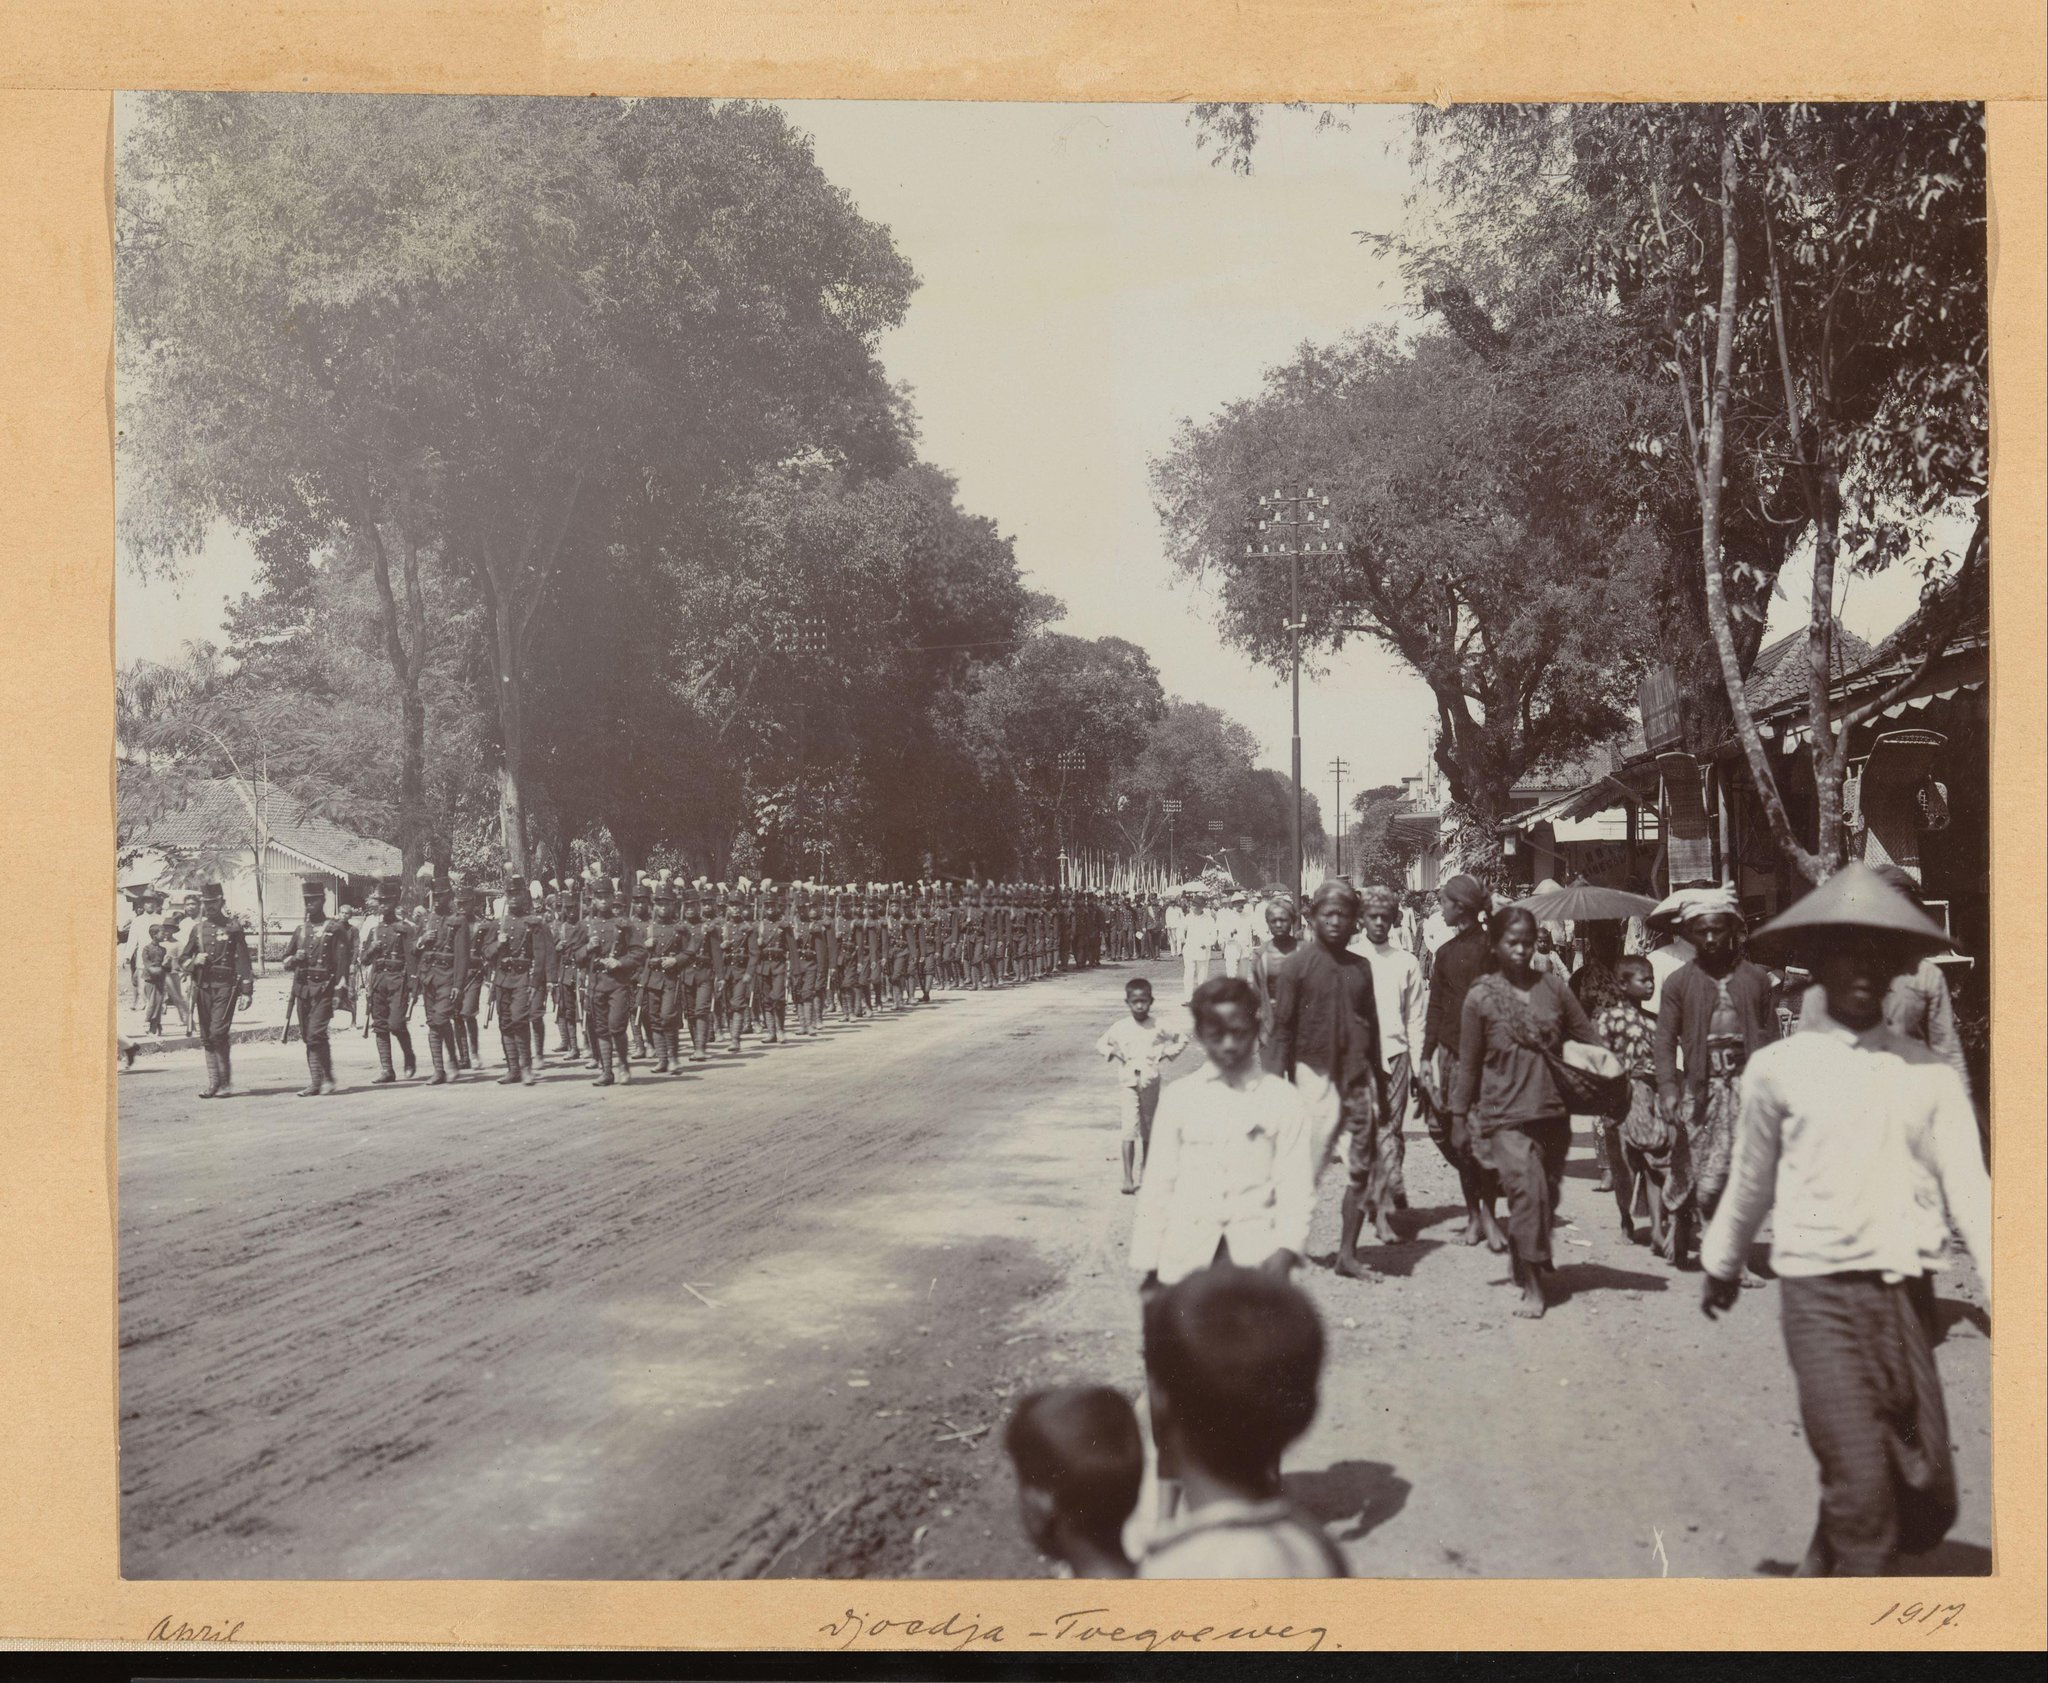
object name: photograph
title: Marcherende Indische militairen en voetgangers op de weg van Jogyakarta naar Toegoe op Java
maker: Anonymous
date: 1904-1917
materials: photographic support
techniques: gelatin silver print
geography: java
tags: troop movements, transportation, street (+ city(-scape) with figures, staffage), java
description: Onderdeel van Familiealbum met foto's van een familie in de voormalige kolonie Nederlands-Indië en van een suikerfabriek in Purworejo.